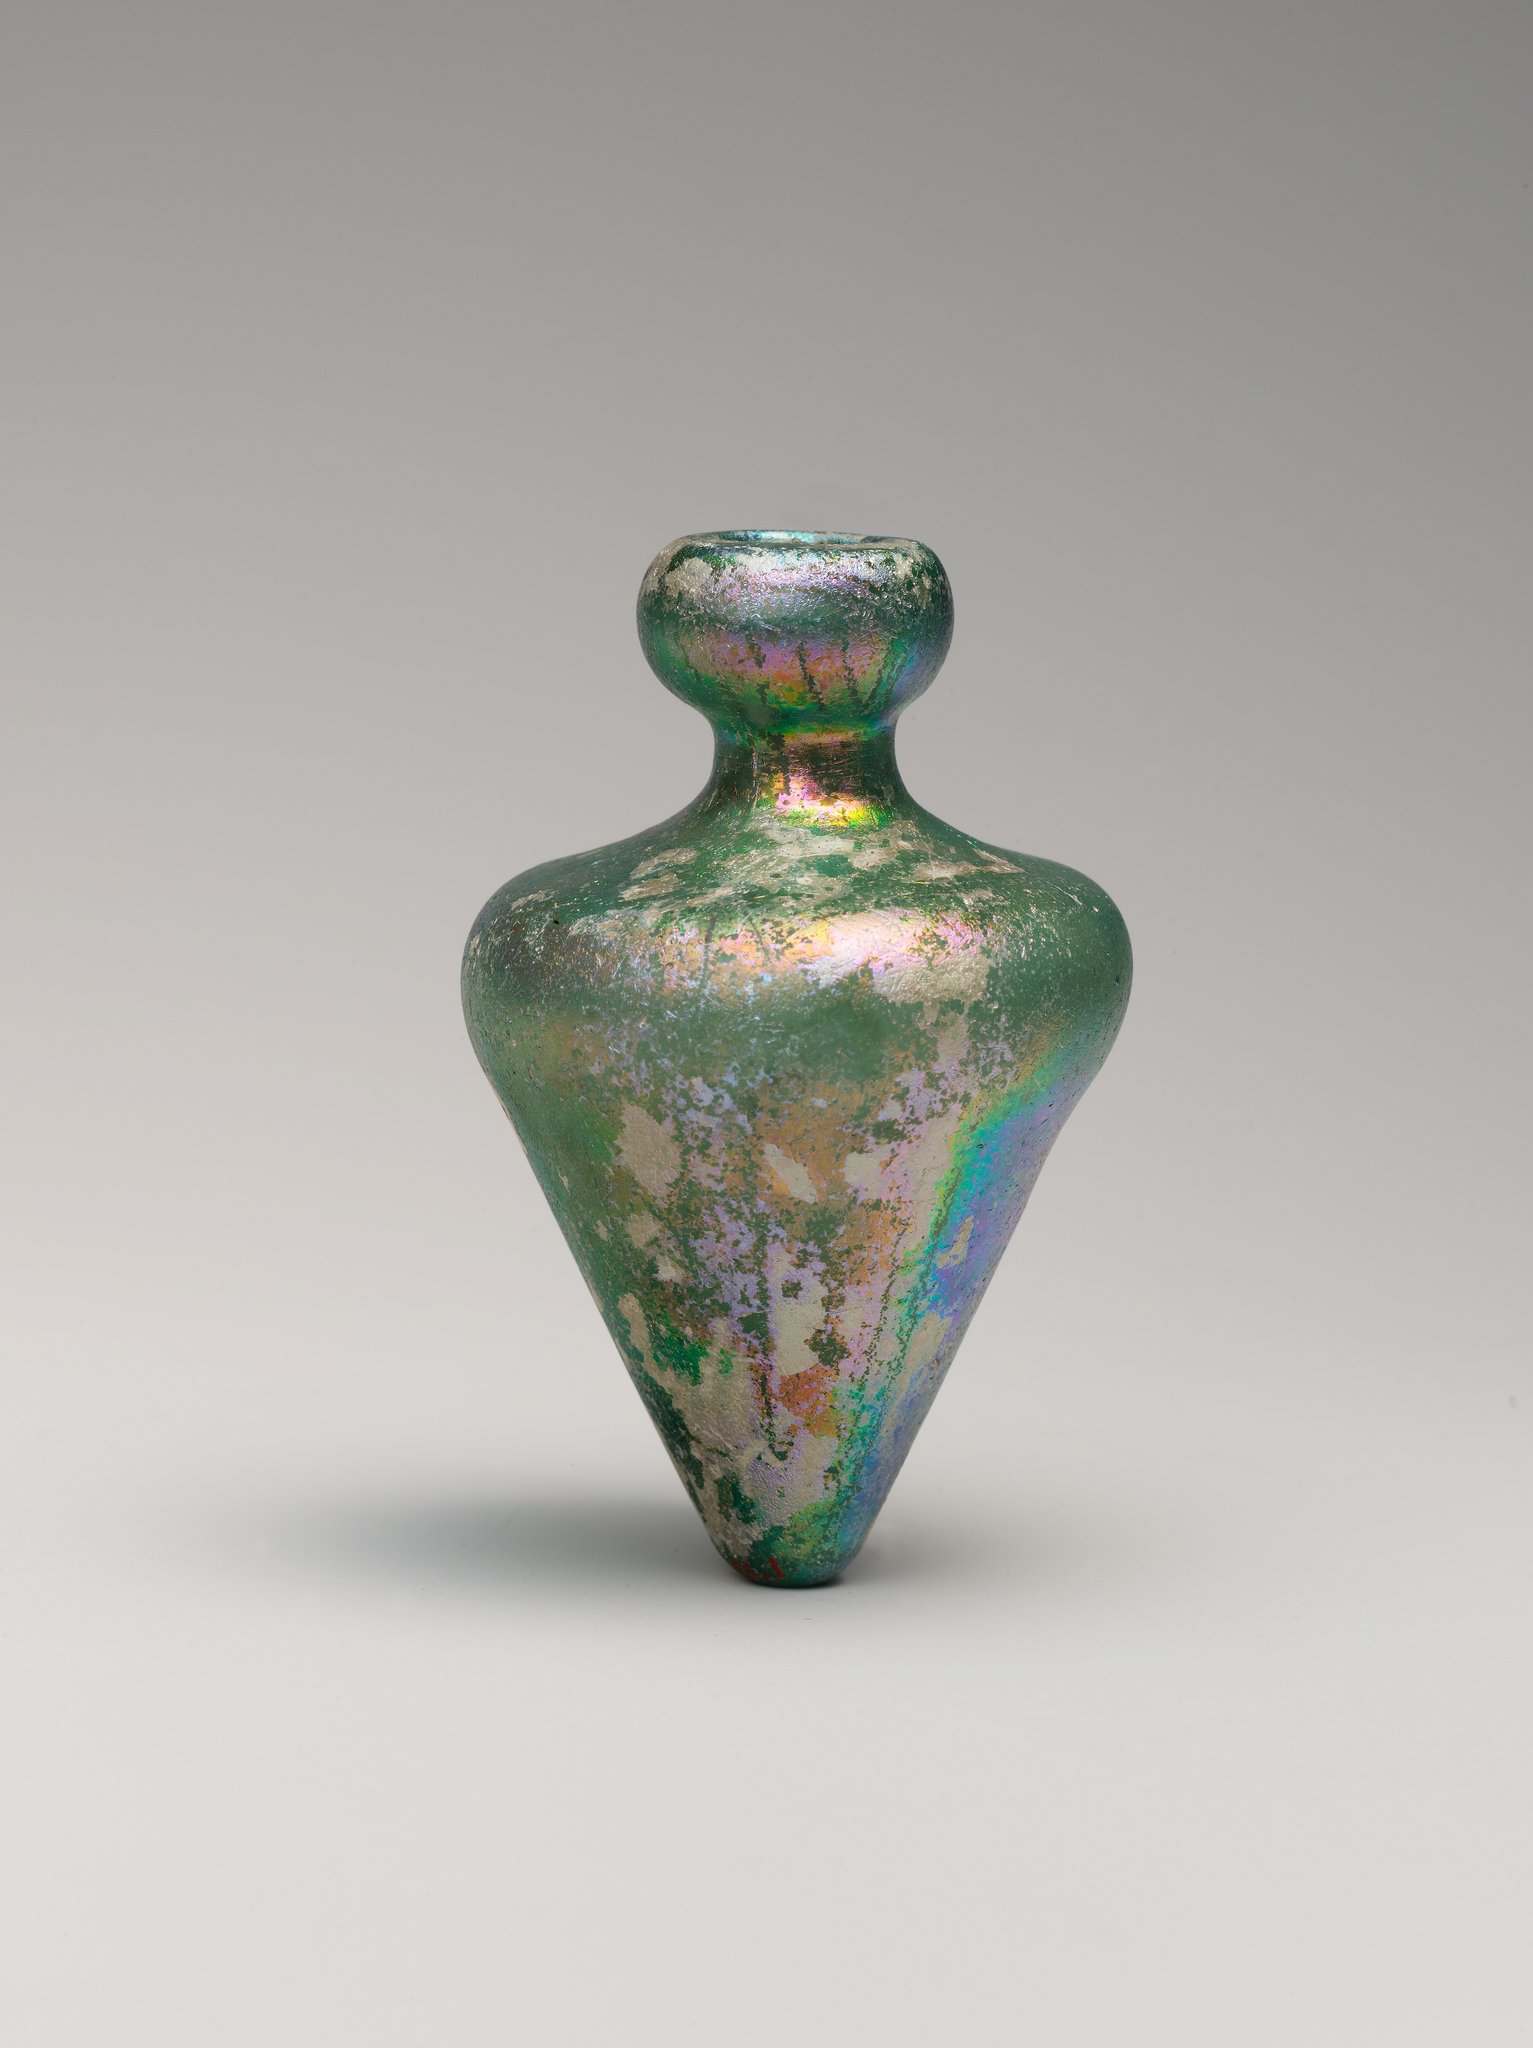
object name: loom weight or vessel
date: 901-1100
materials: glass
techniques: glassblowing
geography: iran